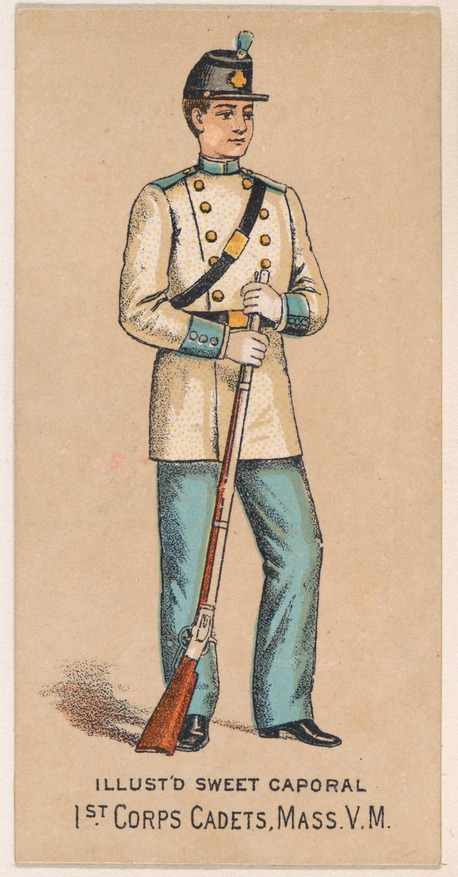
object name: print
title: 1st Corps Cadets, Massachusetts, V.M., from the Military Series (N224) issued by Kinney Tobacco Company to promote Sweet Caporal Cigarettes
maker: kinney brothers tobacco company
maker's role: publisher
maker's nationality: american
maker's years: 1869-2011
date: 1888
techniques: color lithograph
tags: military,men